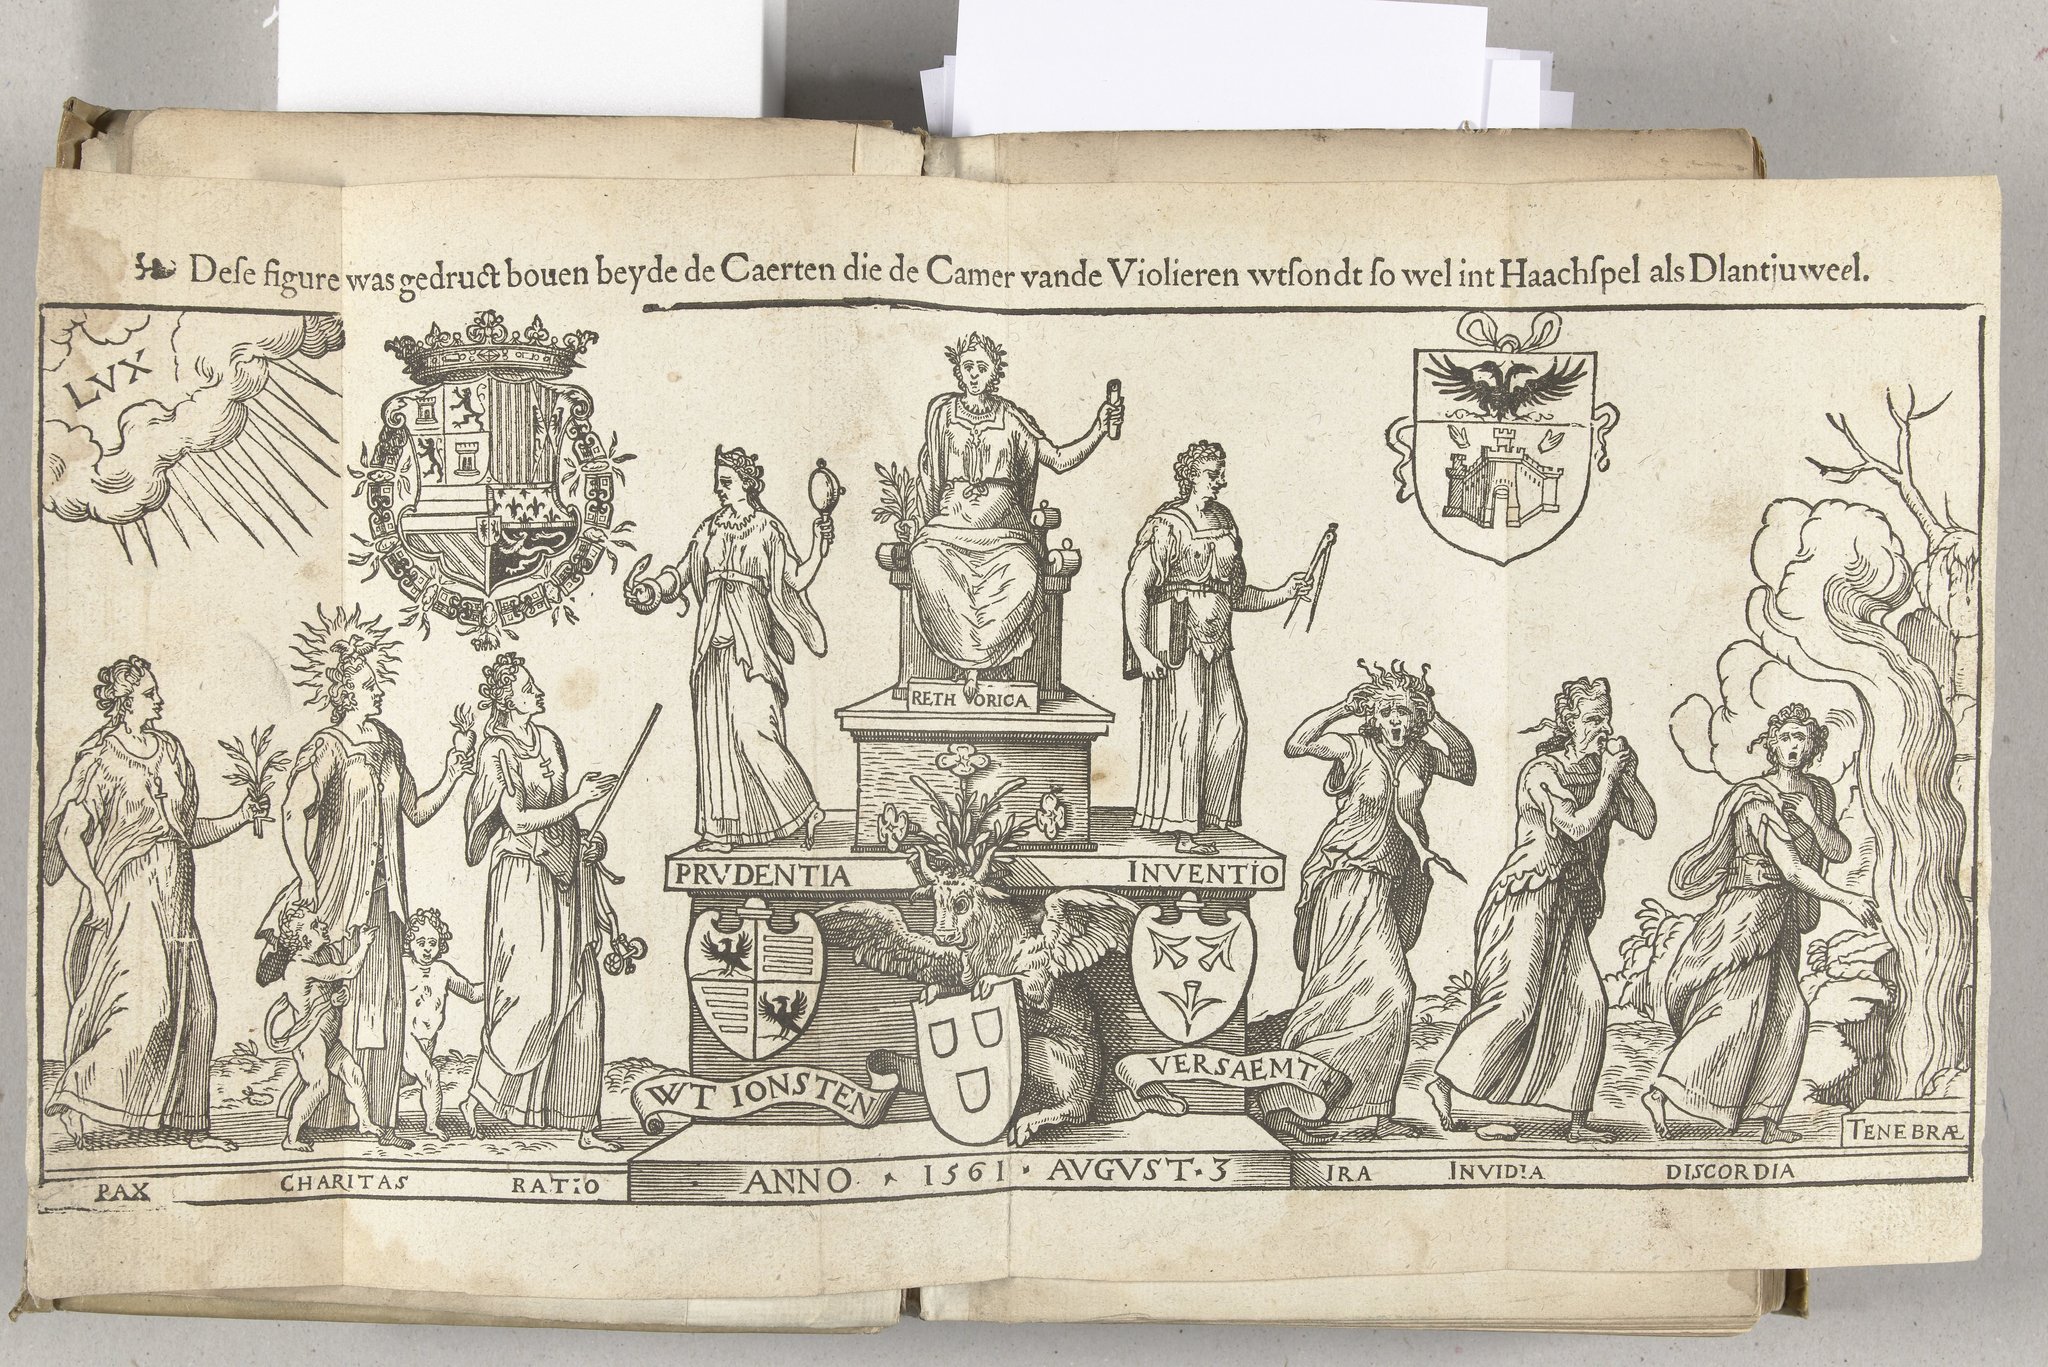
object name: print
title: Die Violiere van Andtweerpen Opsetters des Landt-Iuweels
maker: Anonymous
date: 1561-1562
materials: paper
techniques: woodcut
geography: antwerp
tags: chamber of rhetoric (dutch: 'rederijkerskamer'), antwerp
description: Illustratie in: Spelen van sinne vol scoone moralisacien wtleggingen ende bediedenissen op alle loeflijcke consten waer inne men claerlijck ghelijck in eene spieghel, figuerlijck, poetelijck en retorijckelijck mach aenschouwen hoe nootsakelijck ende dienstelijck die selve consten allen menschen zijn : ghespeelt met octroy der Con. Ma. binnen der stadt van Andtwerpen op dLant-Juweel by die veerthien cameren van Retorijcken die hen daer ghepresenteert hebben den derden dach Augusti int Jaer ons Heeren 1561, op die questie : wat den mensch aldermeest tot conste verwect. Uitgave van 1562, p. C (1). In het exemplaar in de Rijksmuseum Research Library, signatuur: 325 D 20.